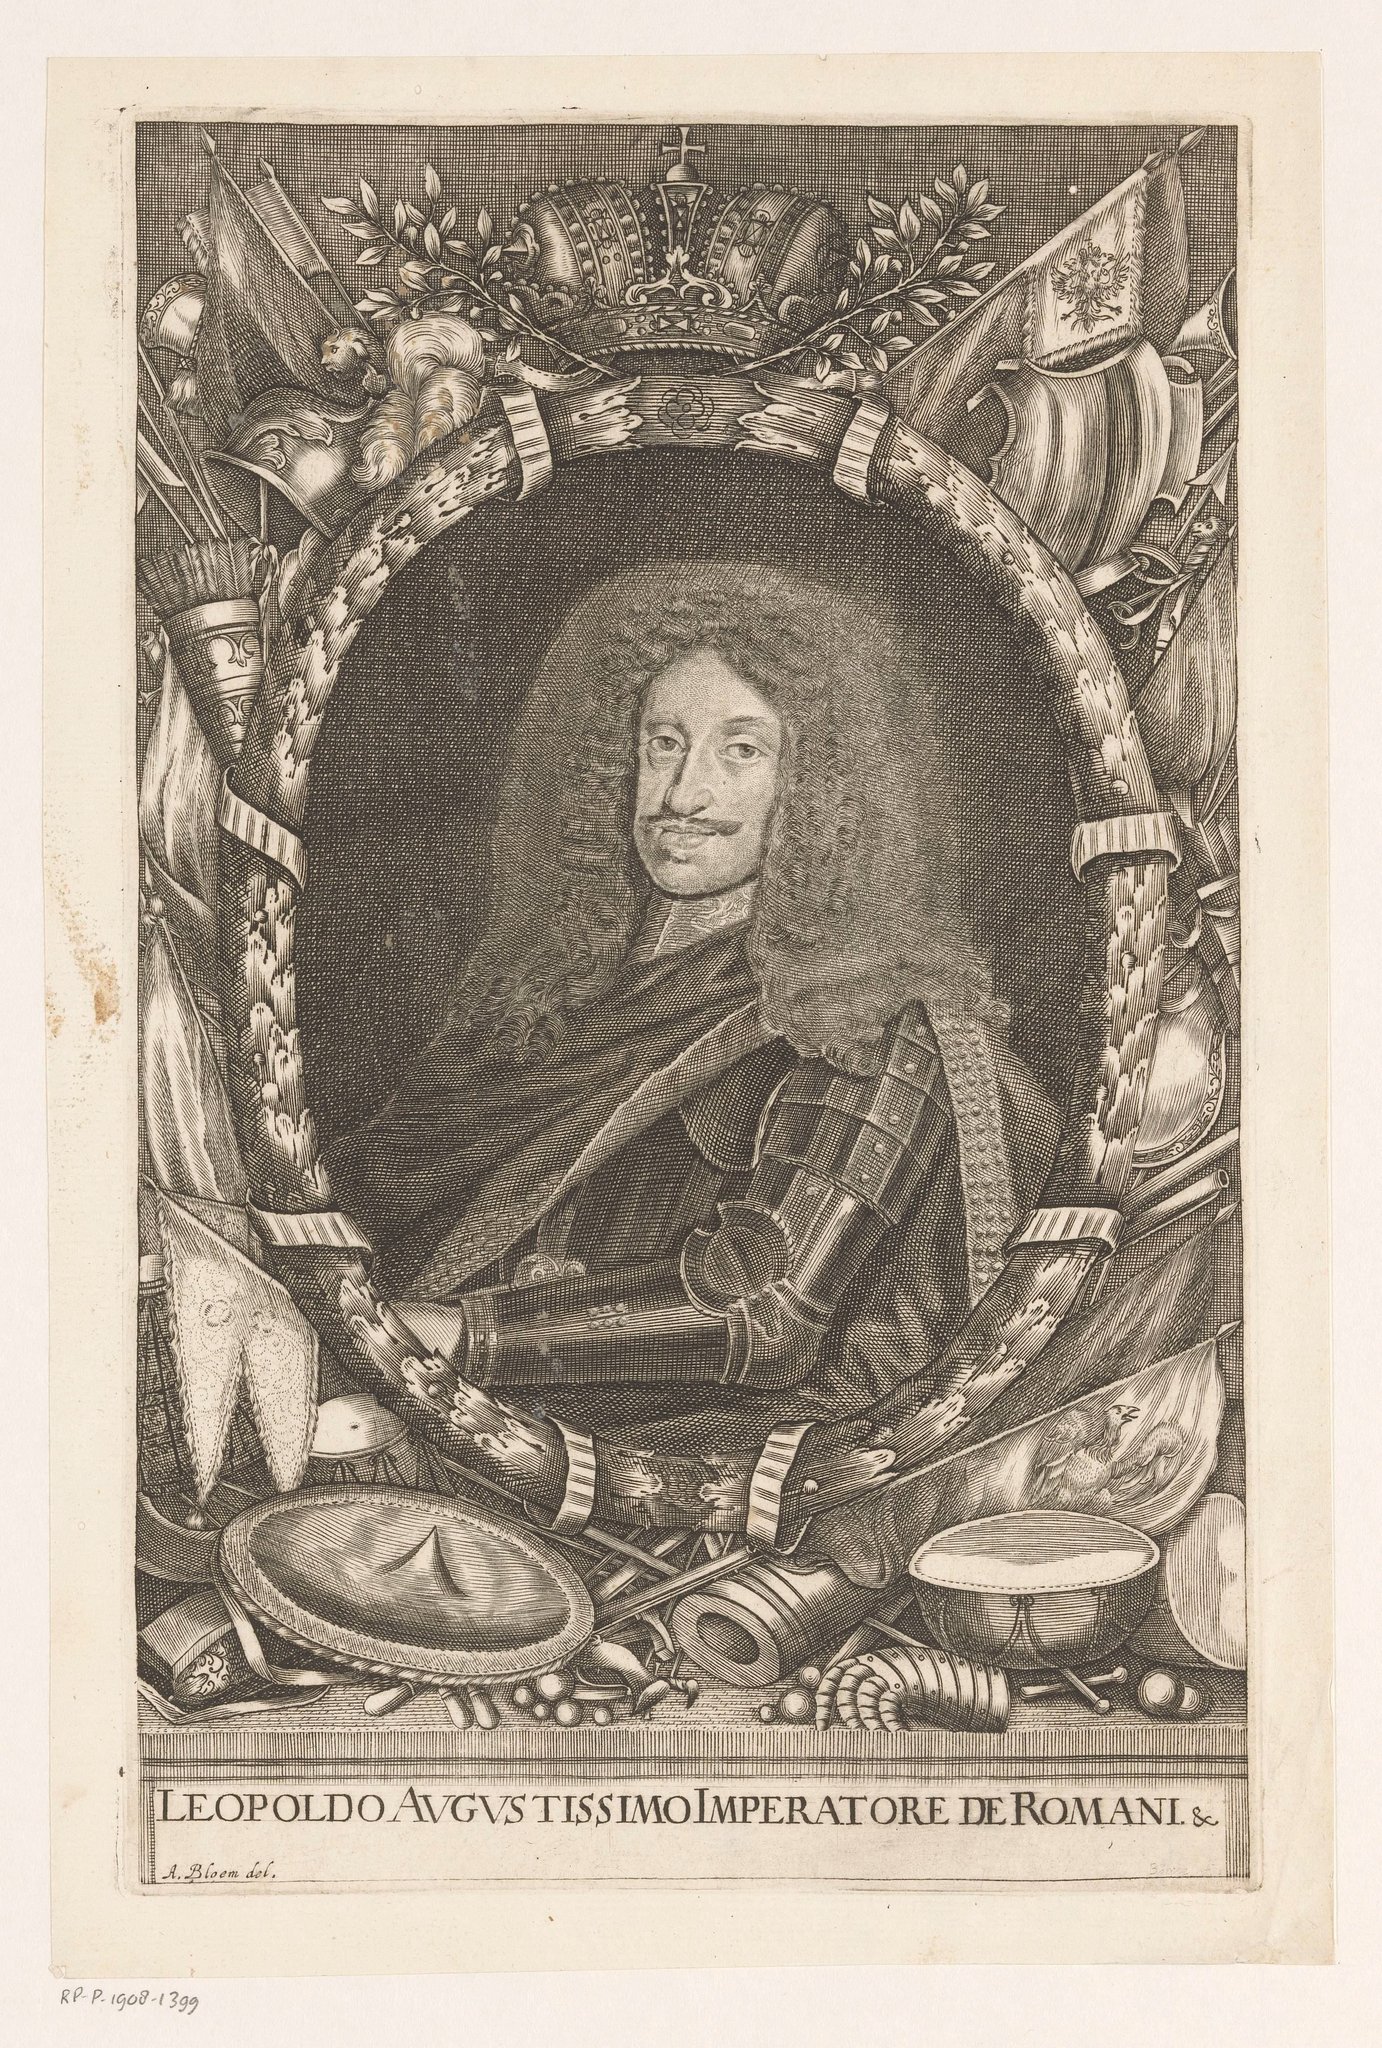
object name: print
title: Portret van keizer Leopold I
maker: adriaen van bloemen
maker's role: draughtsman, painter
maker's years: 1639-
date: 1674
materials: paper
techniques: engraving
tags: leopold i (keizer van duitsland), crown (symbol of sovereignty), armour, historical persons, weapons, banner, standard (as symbol of the state, etc.)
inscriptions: collector's mark: Lugt 2228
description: Prent ook gebruikt in: Gualdo Priorato, Galeazzo. Historia di Leopoldo Cesare. 3 dln. Wenen: Johann Baptist Hacque, 1670-1674, dl. 3 [1674].